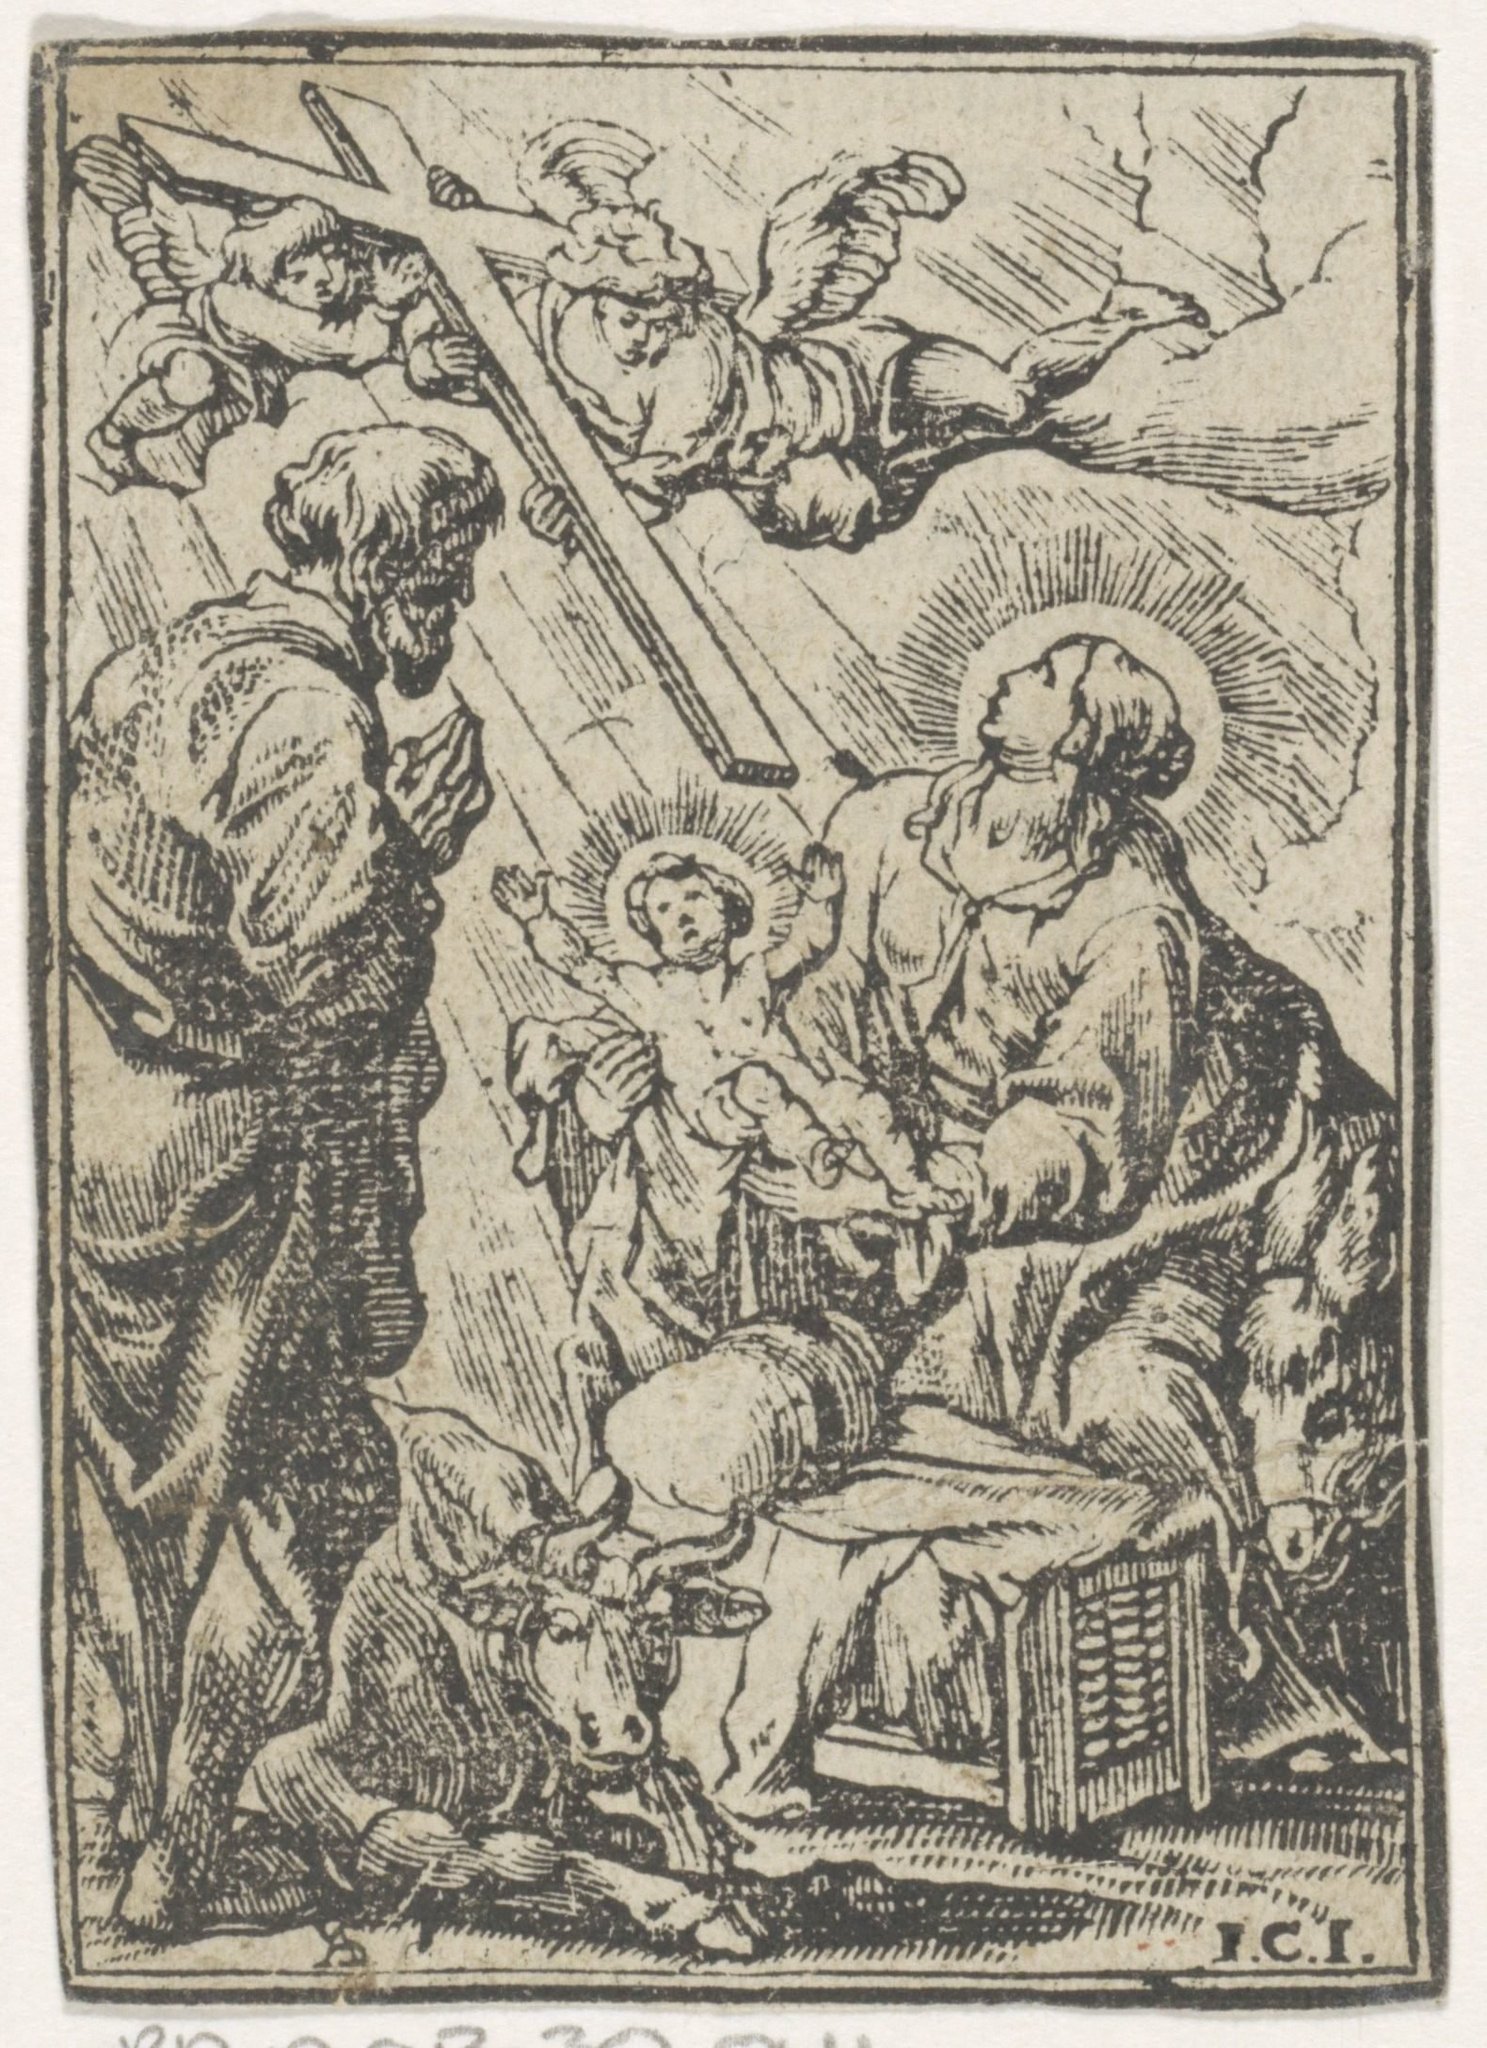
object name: book illustration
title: Geboorte van Christus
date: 1649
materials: paper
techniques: letterpress printing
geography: antwerp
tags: mary, joseph and the new-born christ (nativity)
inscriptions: collector's mark: Lugt 240, collector's mark: Lugt 698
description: Maria staat met het Christuskind in haar armen in de stal met de os en de ezel. Jozef staat naast de kribbe te bidden. Twee engelen houden een groot kruis boven het Christuskind.